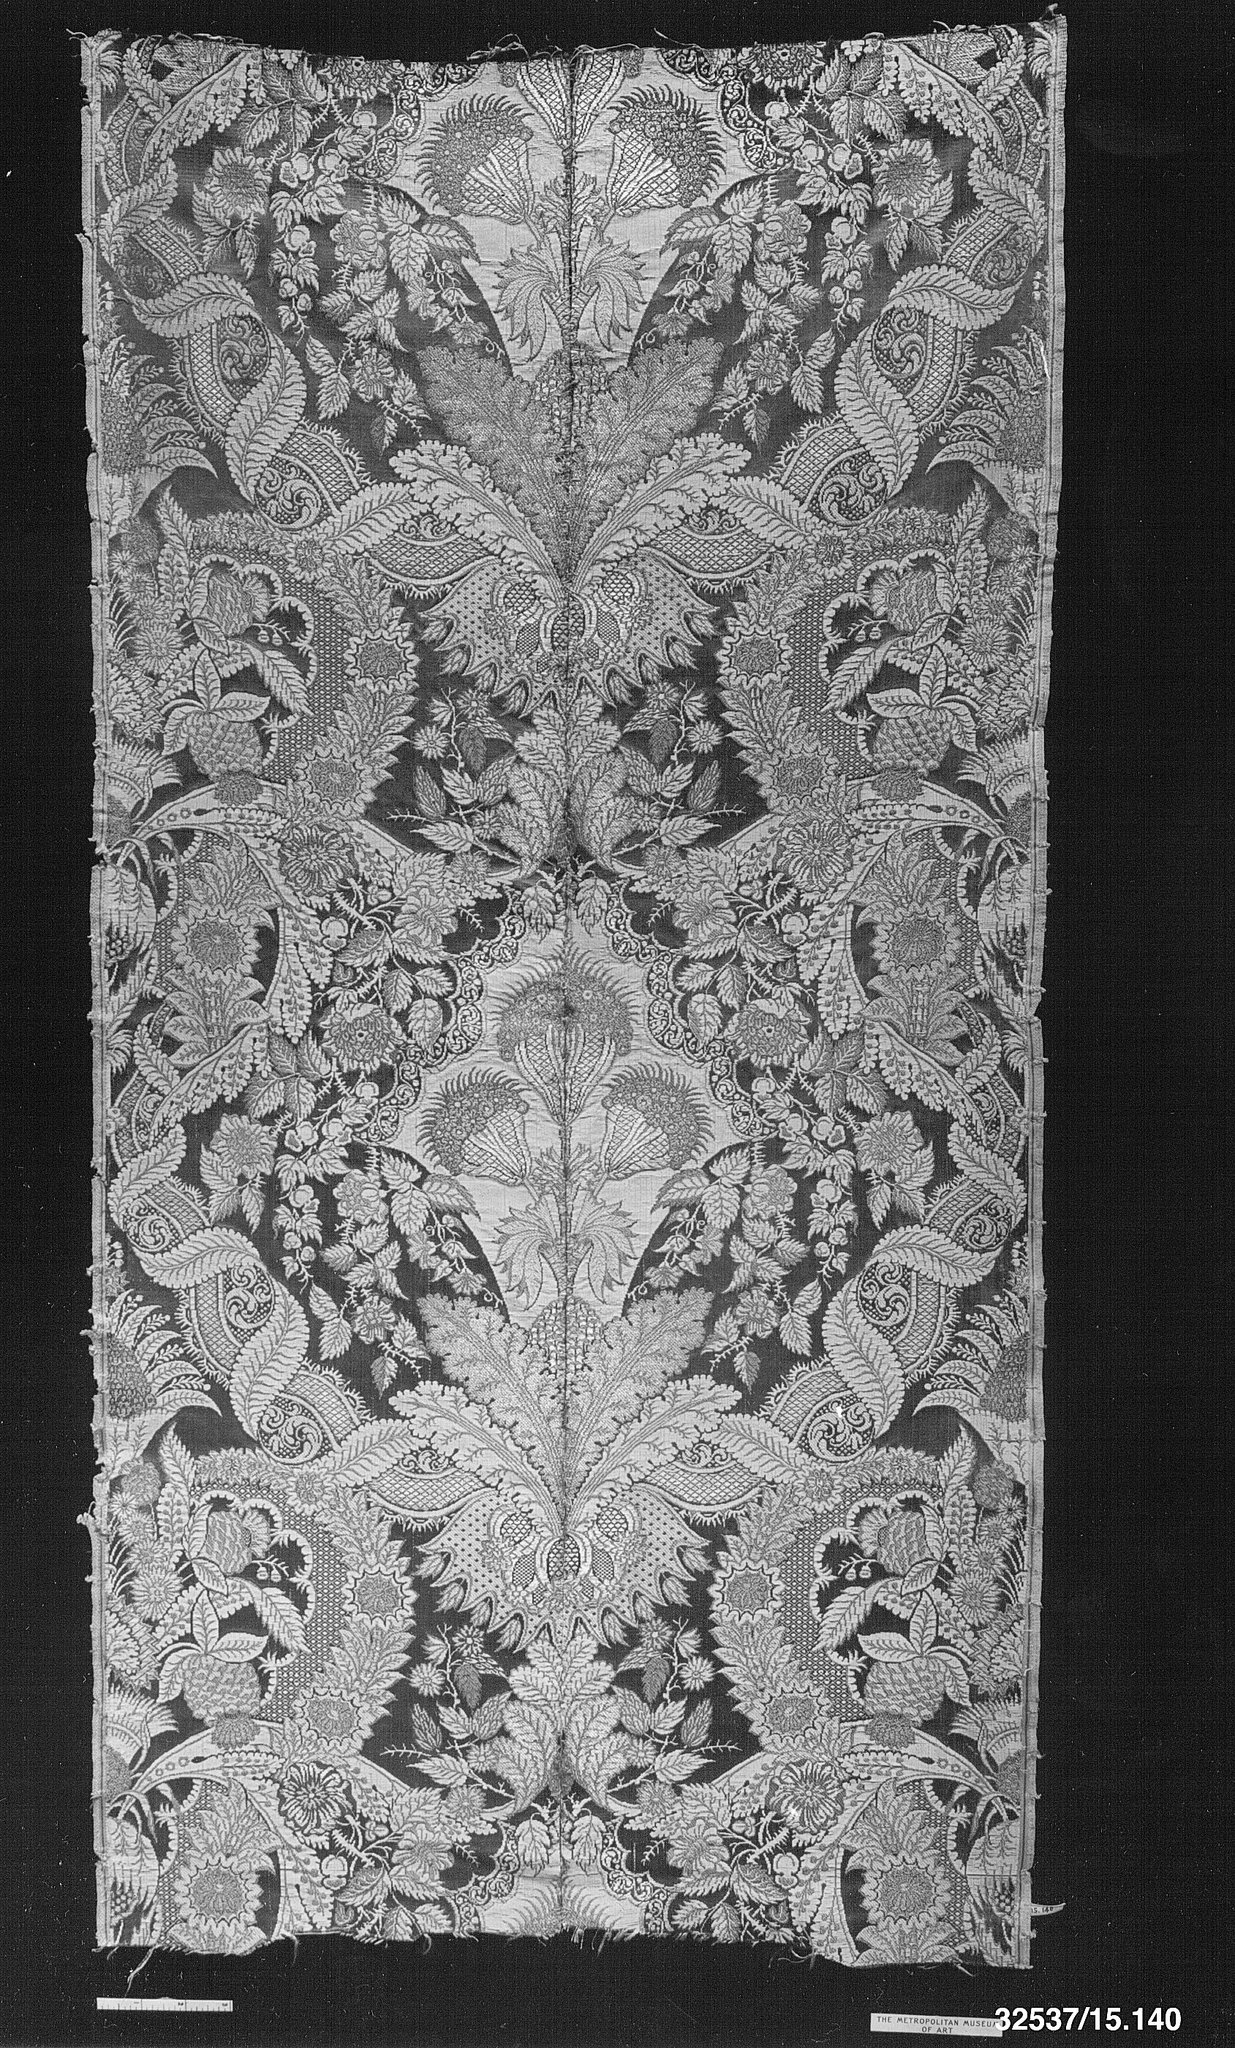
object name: piece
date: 1725-1730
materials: metal thread, silk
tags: flowers,leaves